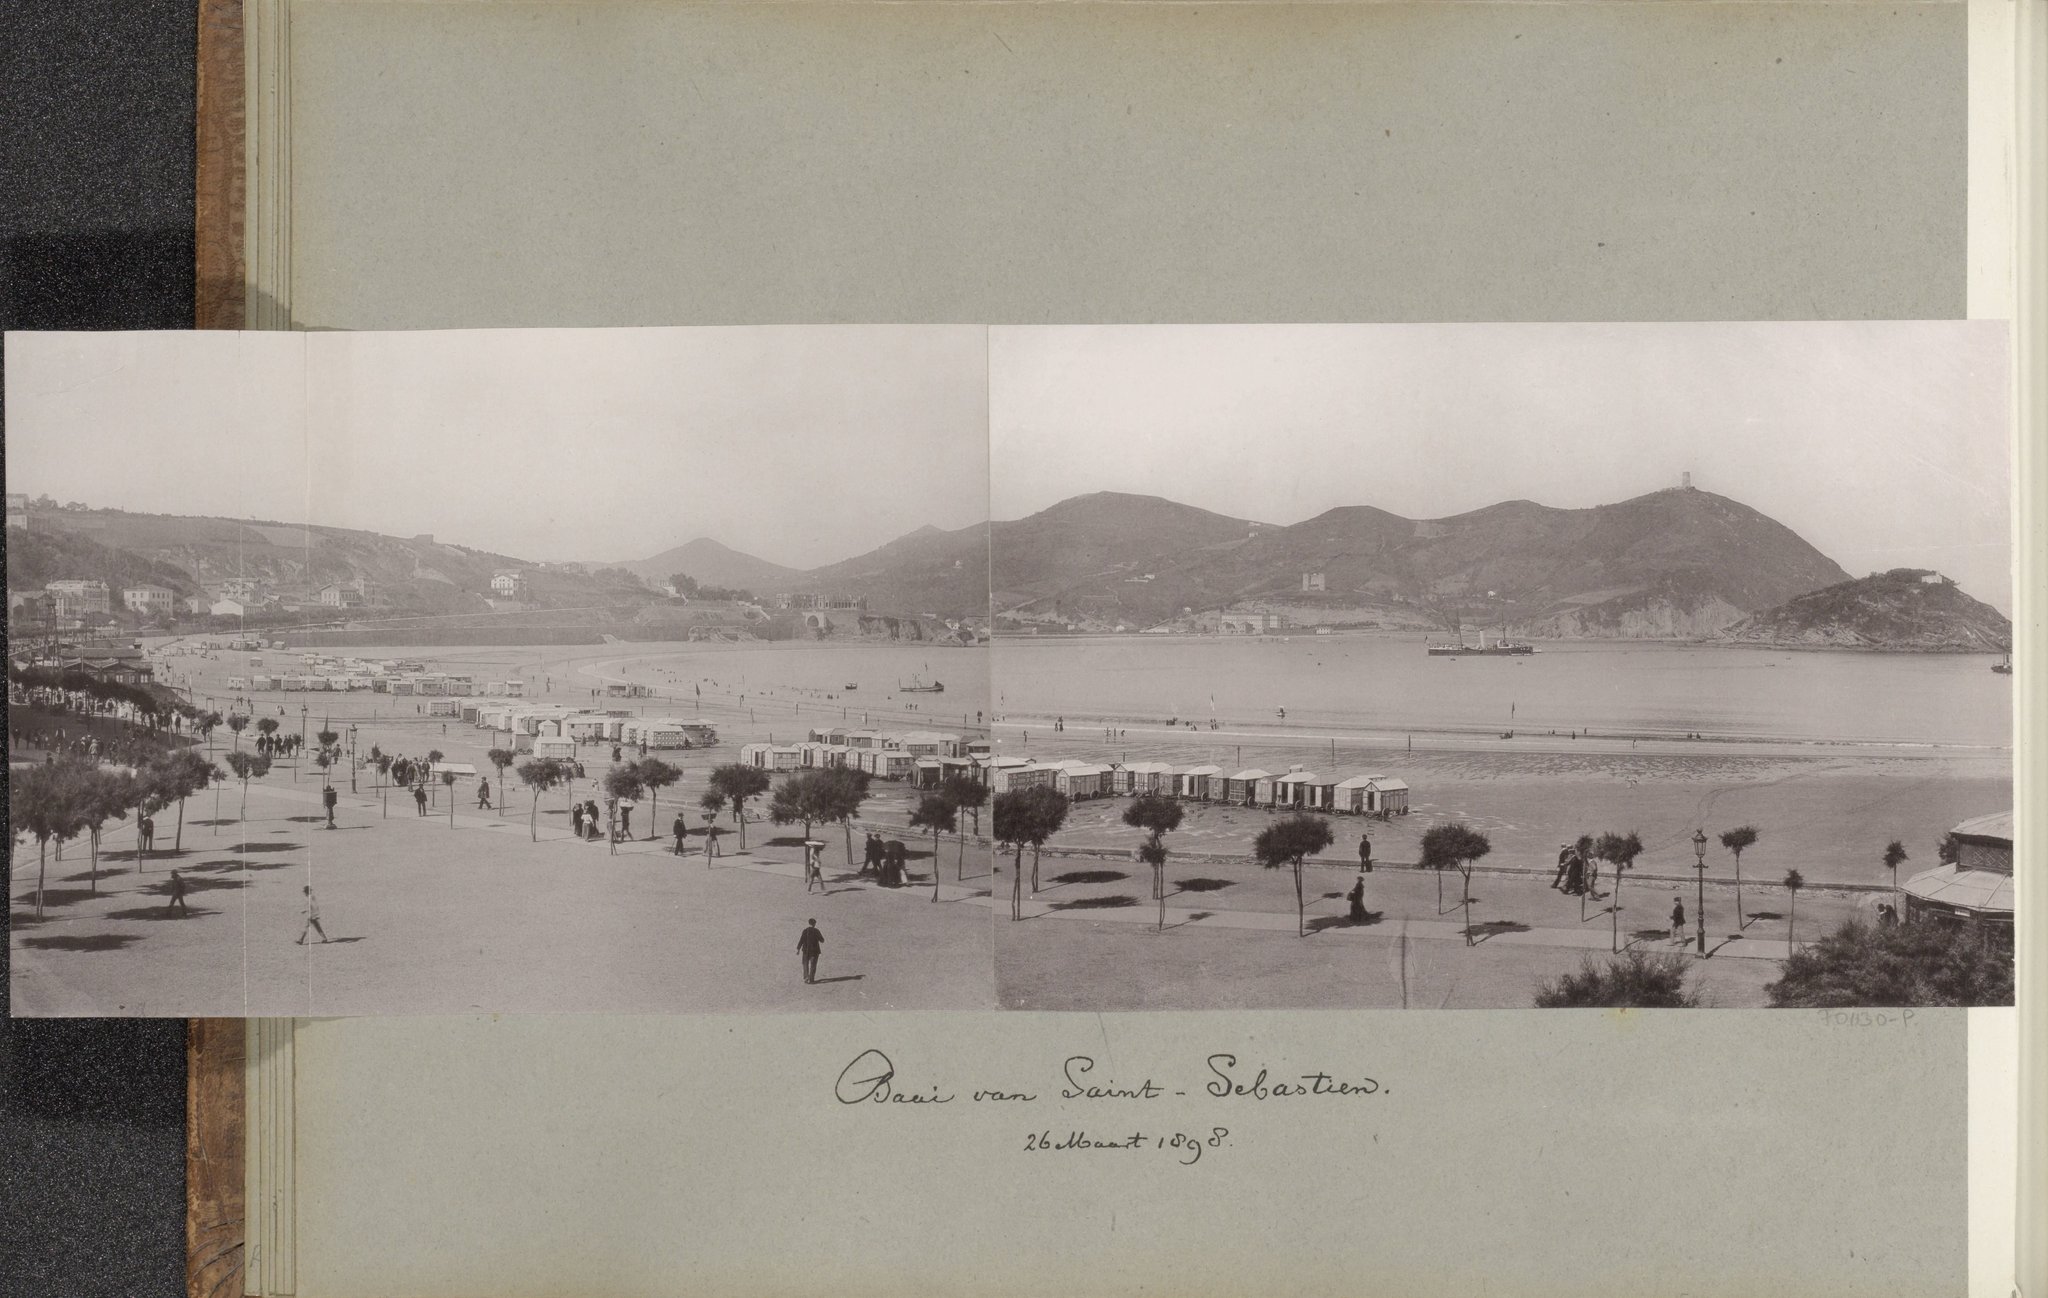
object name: photograph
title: Panorama van de baai van San Sebastián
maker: Anonymous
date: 1880-1898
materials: paper, ink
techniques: photograph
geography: donostia-san sebastián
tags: gulf, bay (+ landscape with figures, staffage), prospect of city, town panorama, silhouette of city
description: Panorama van de baai van San Sebastián bestaande uit twee afdrukken. Het linkerdeel van de linkerafdruk is omgevouwen. Onderdeel van Reisalbum met foto's van bezienswaardigheden in Frankrijk, Spanje, Italië, Duitsland, Zwitserland en Oostenrijk.